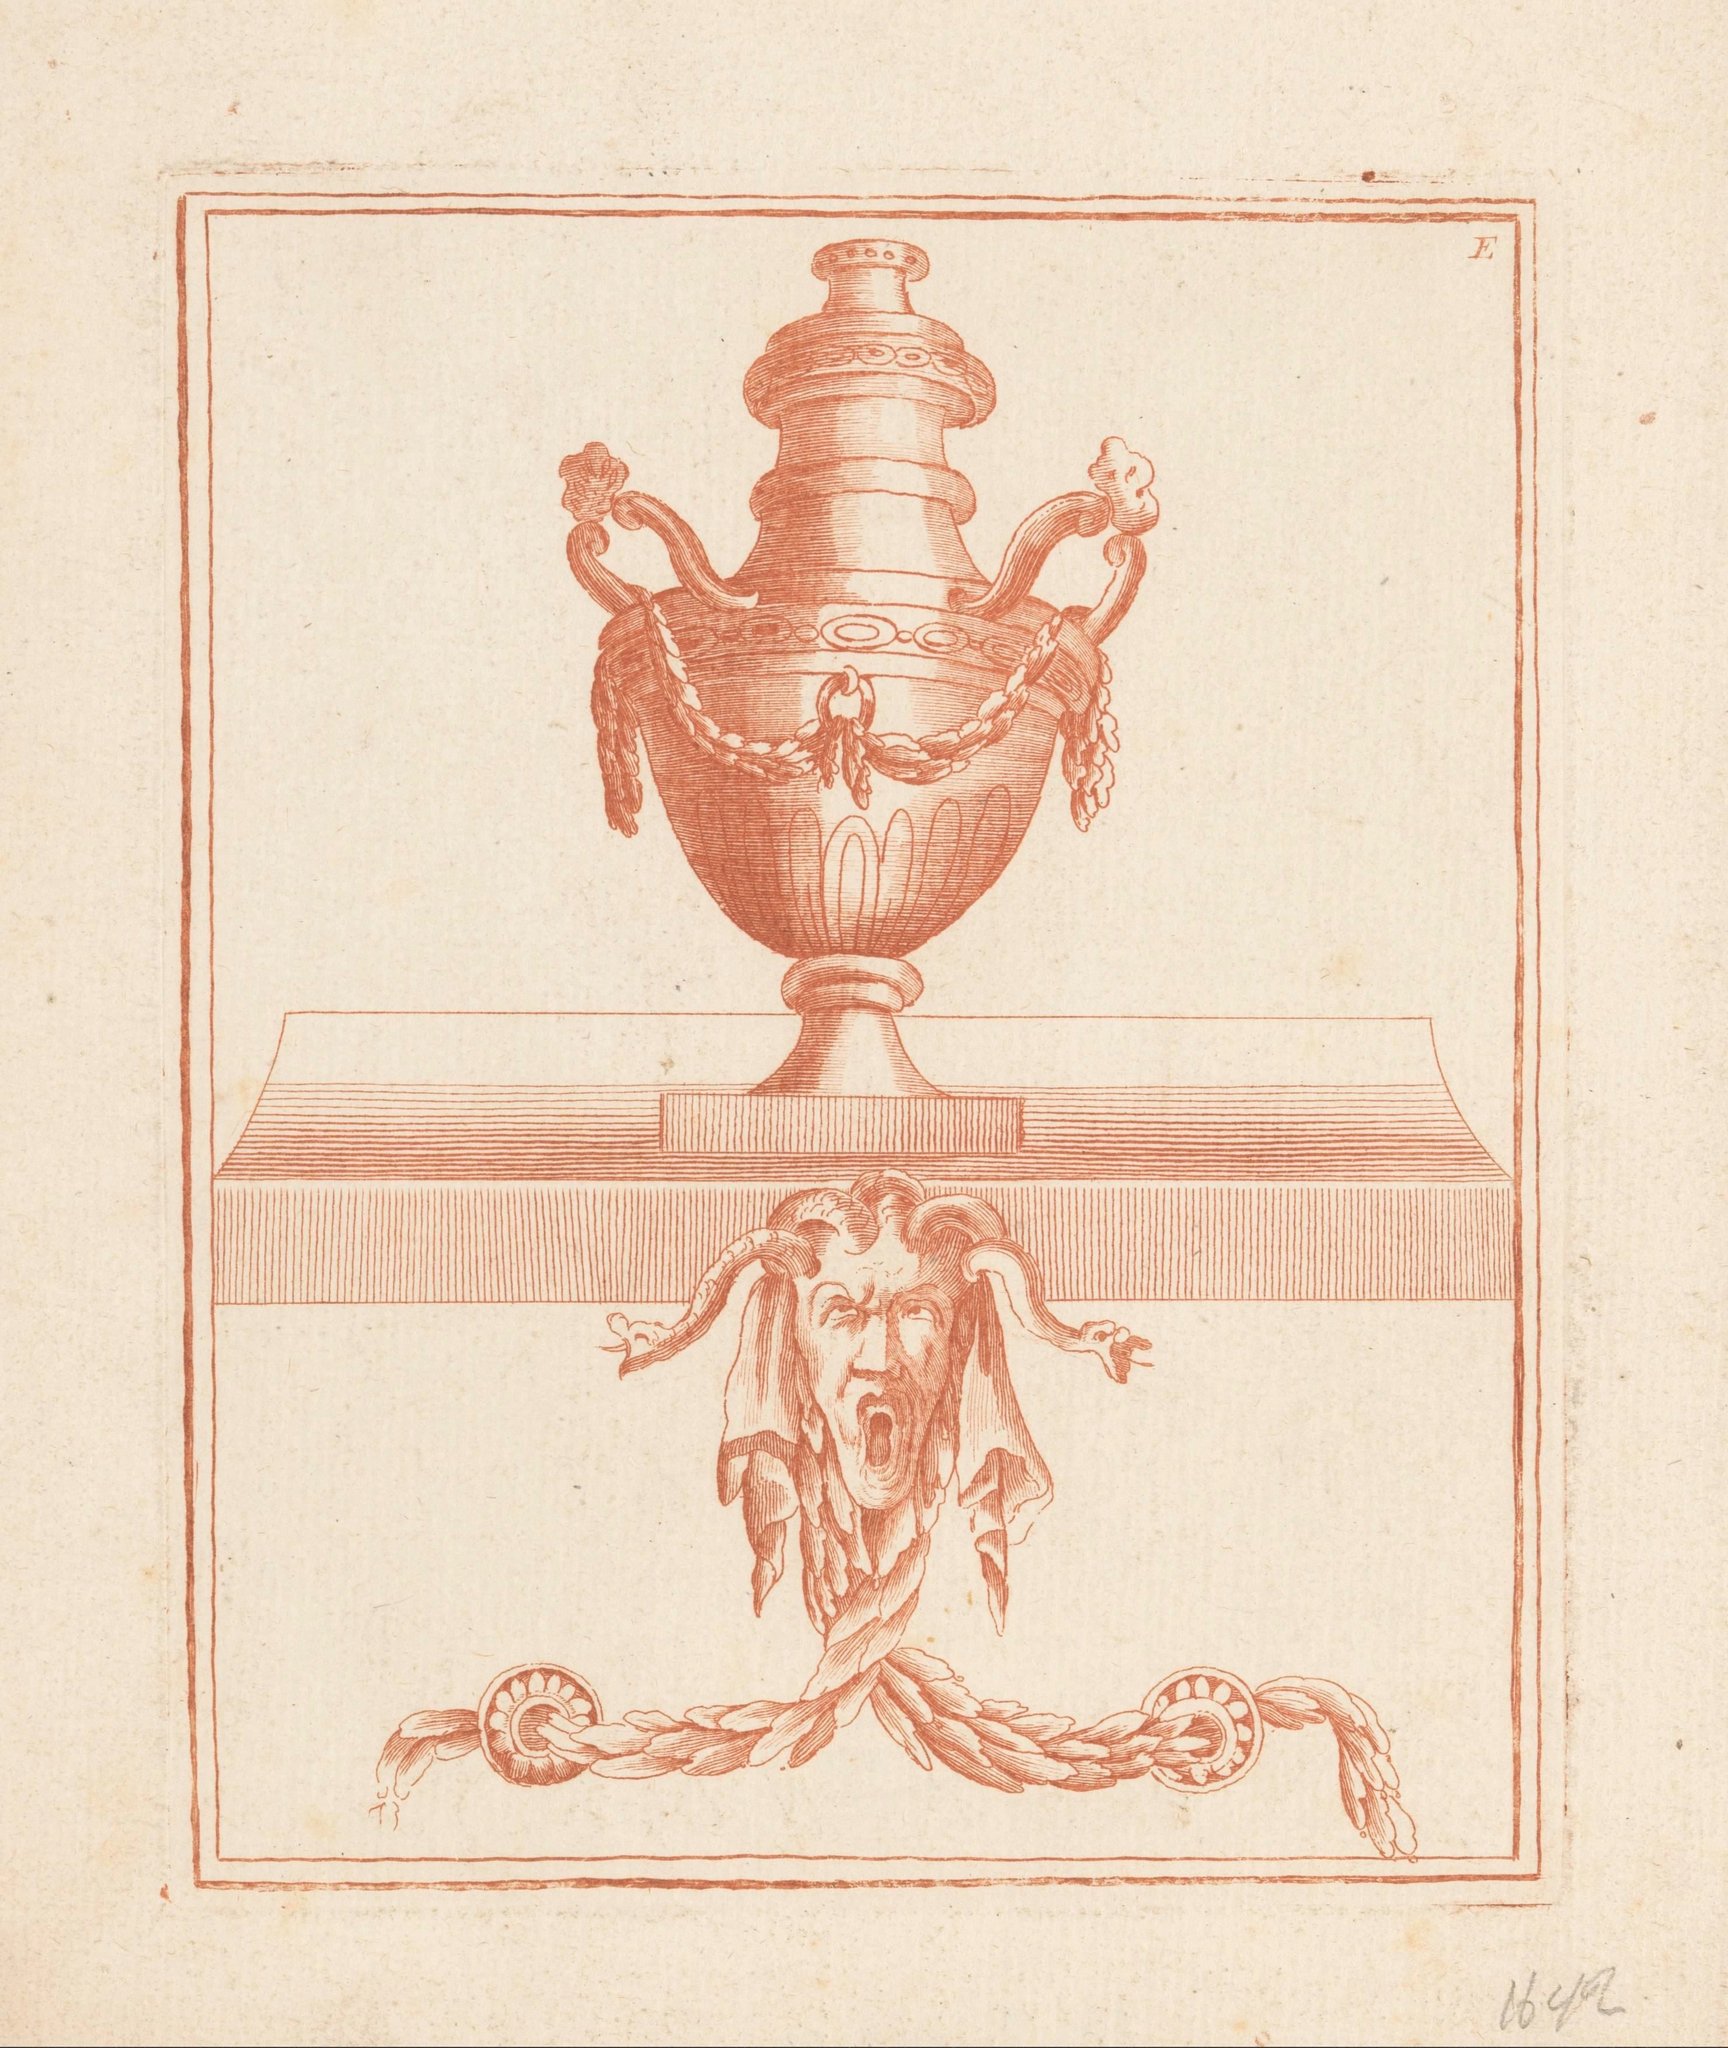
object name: print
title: Vaas en masker met slangen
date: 1770-1780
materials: paper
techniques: etching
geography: paris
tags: vase ~ ornament, mask, mascaron ~ ornament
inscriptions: collector's mark: Lugt 2228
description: Een neoklassieke vaas met guirlandes. Daaronder een masker met slangen, draperieën en guirlandes.